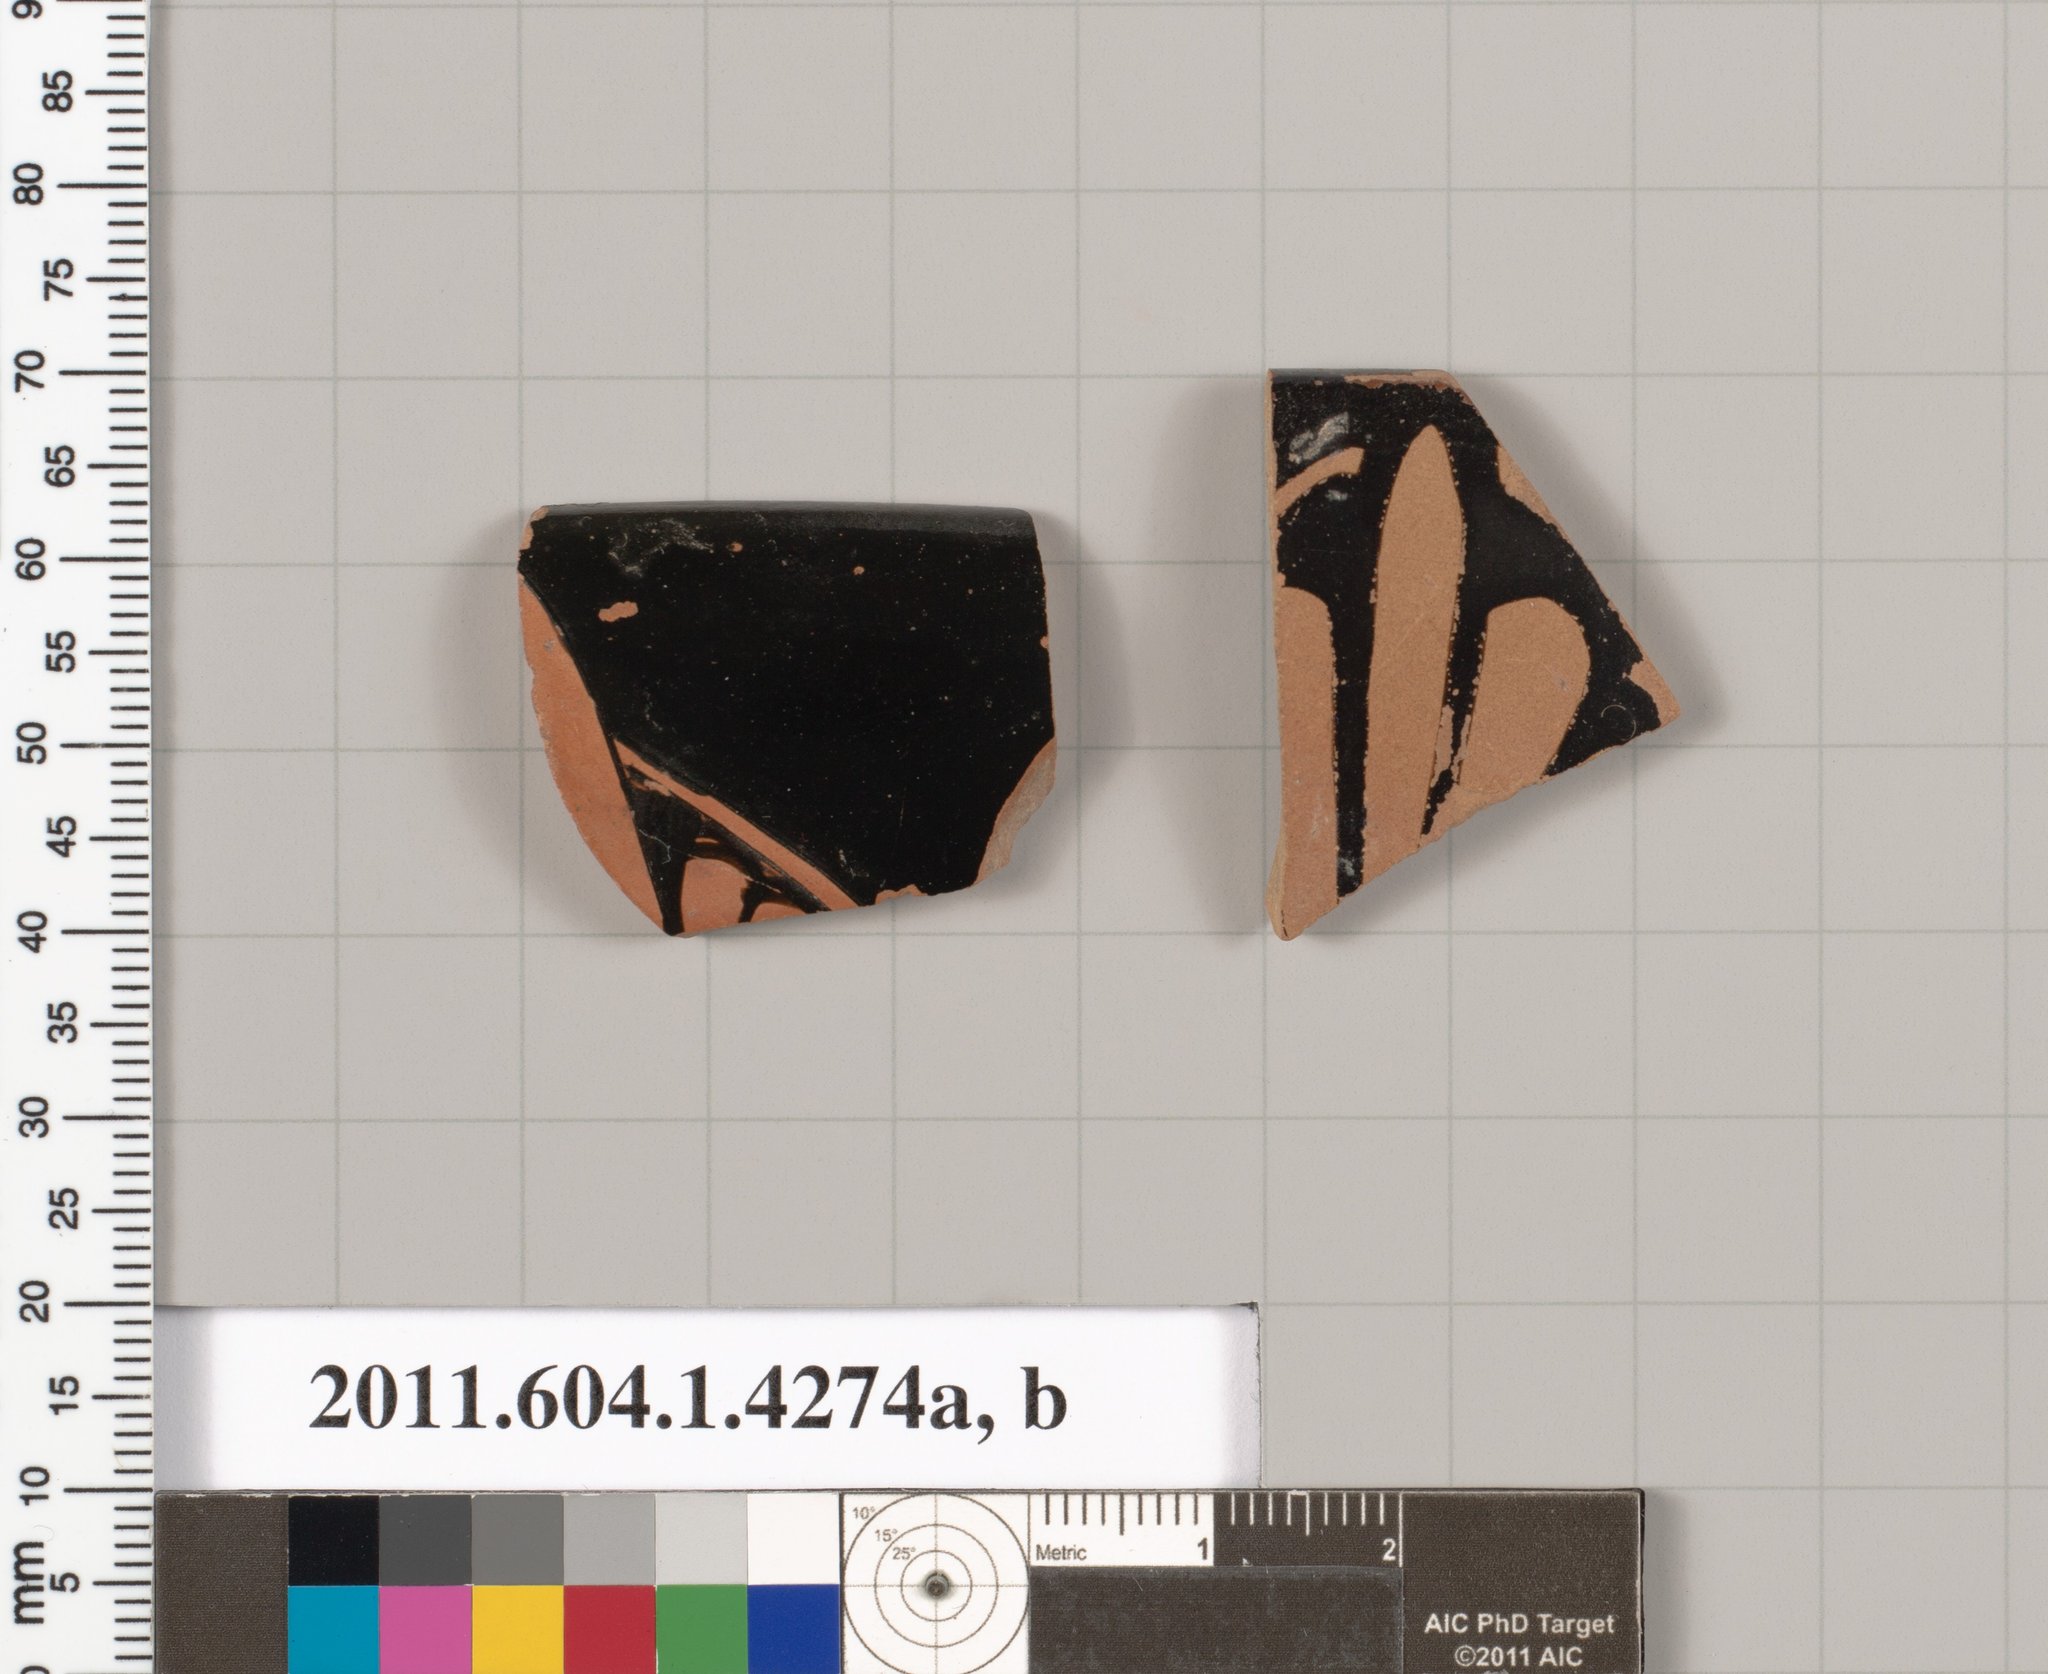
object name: kylix fragment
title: Terracotta rim fragments of kylikes (drinking cups)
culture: greek, attic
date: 500-451 BCE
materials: terracotta